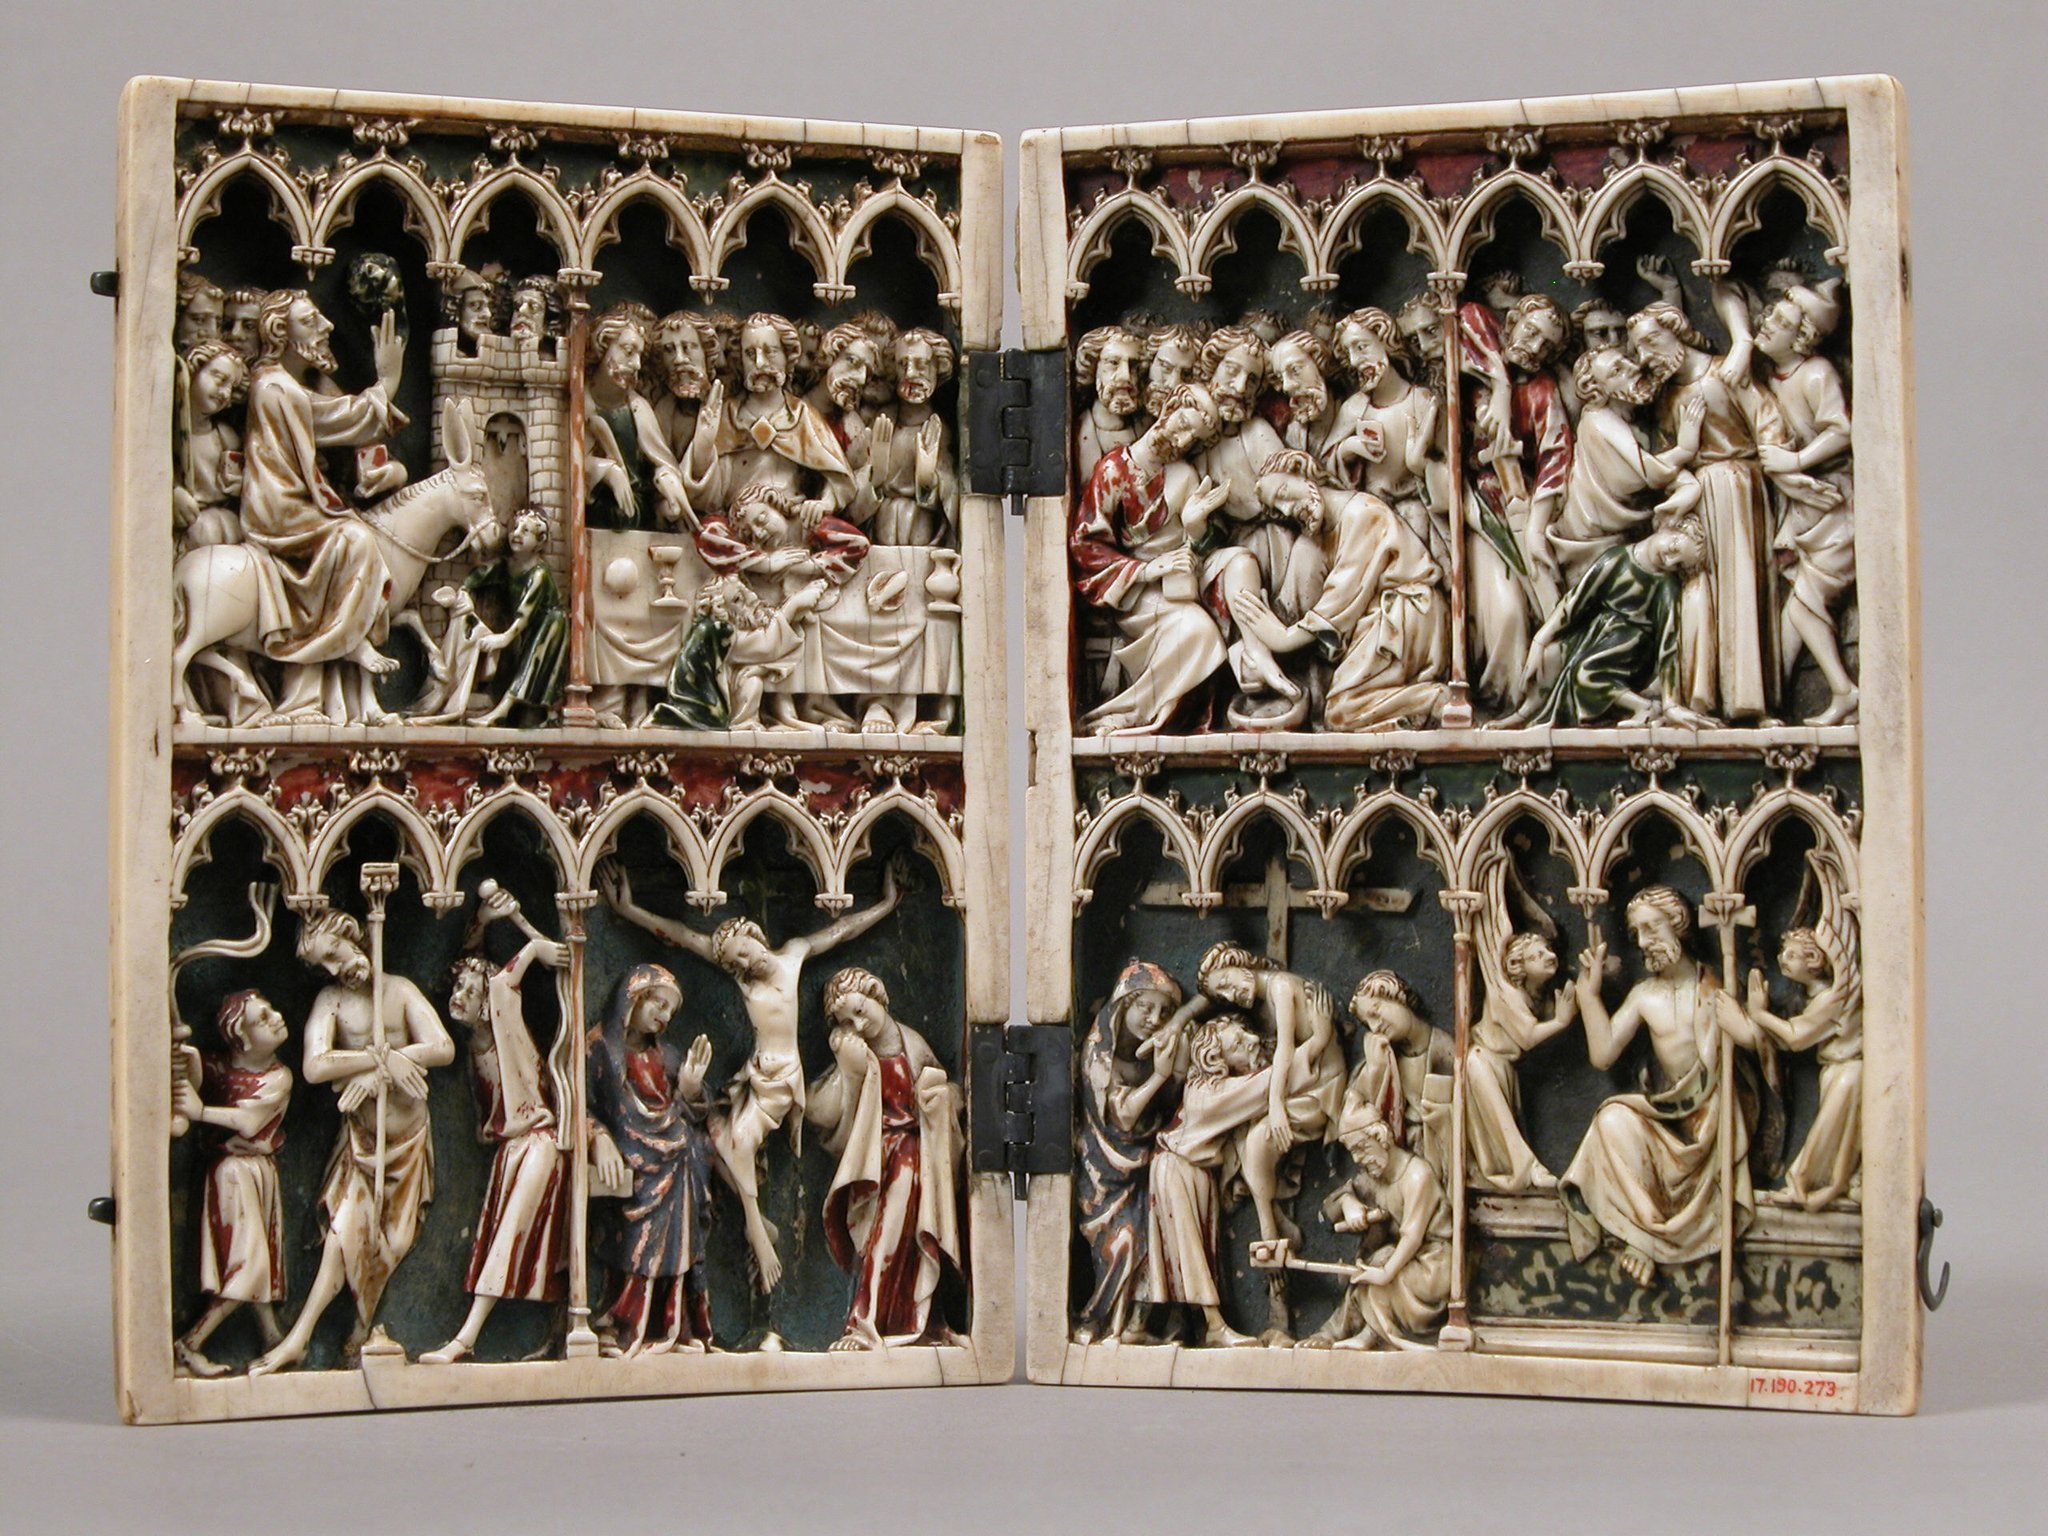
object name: diptych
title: Diptych with Scenes from the Passion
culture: french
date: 1301-1400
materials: ivory, metal, paint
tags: donkeys,christ,virgin mary,crucifixion,descent from the cross,last supper